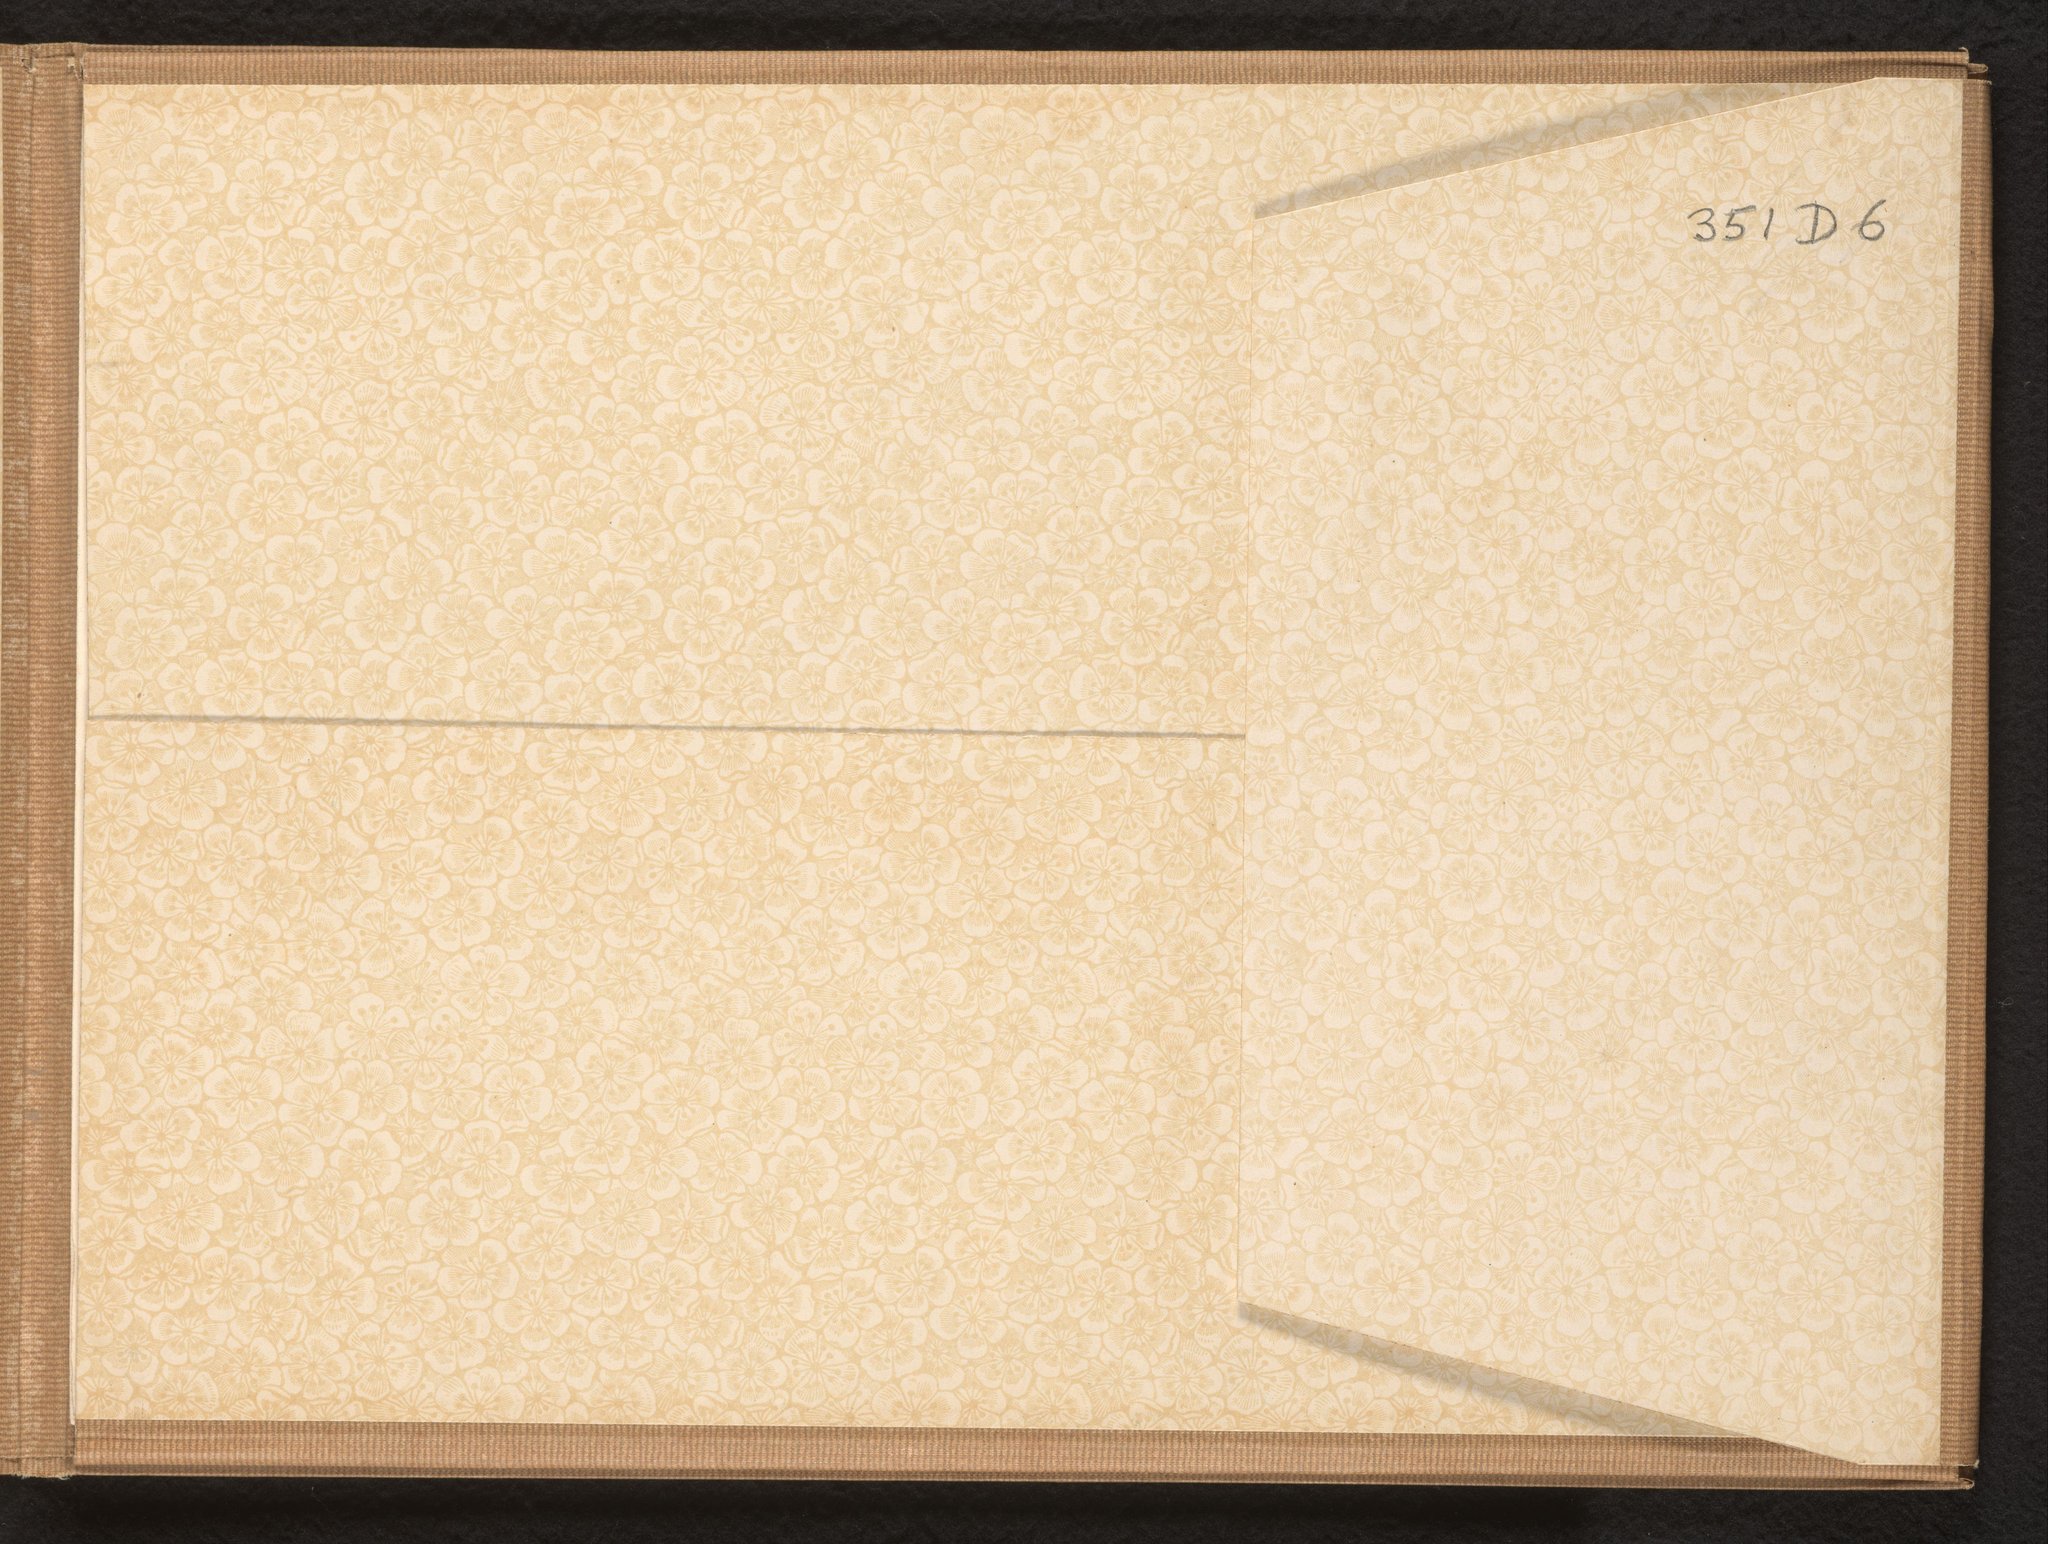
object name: wrapper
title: Is fotografie kunst?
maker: laurens hansma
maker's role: publisher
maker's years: 1860-1920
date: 1905-1906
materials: cardboard, paper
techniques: photoaquatint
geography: apeldoorn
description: Omslag met 12 heliogravures van verschillende fotografen.